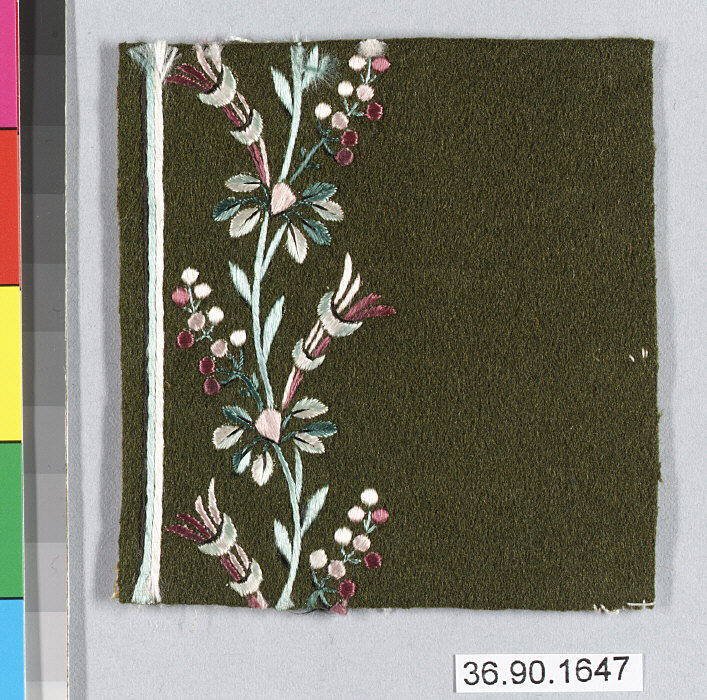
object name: sample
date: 1801-1833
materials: felt, silk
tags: flowers